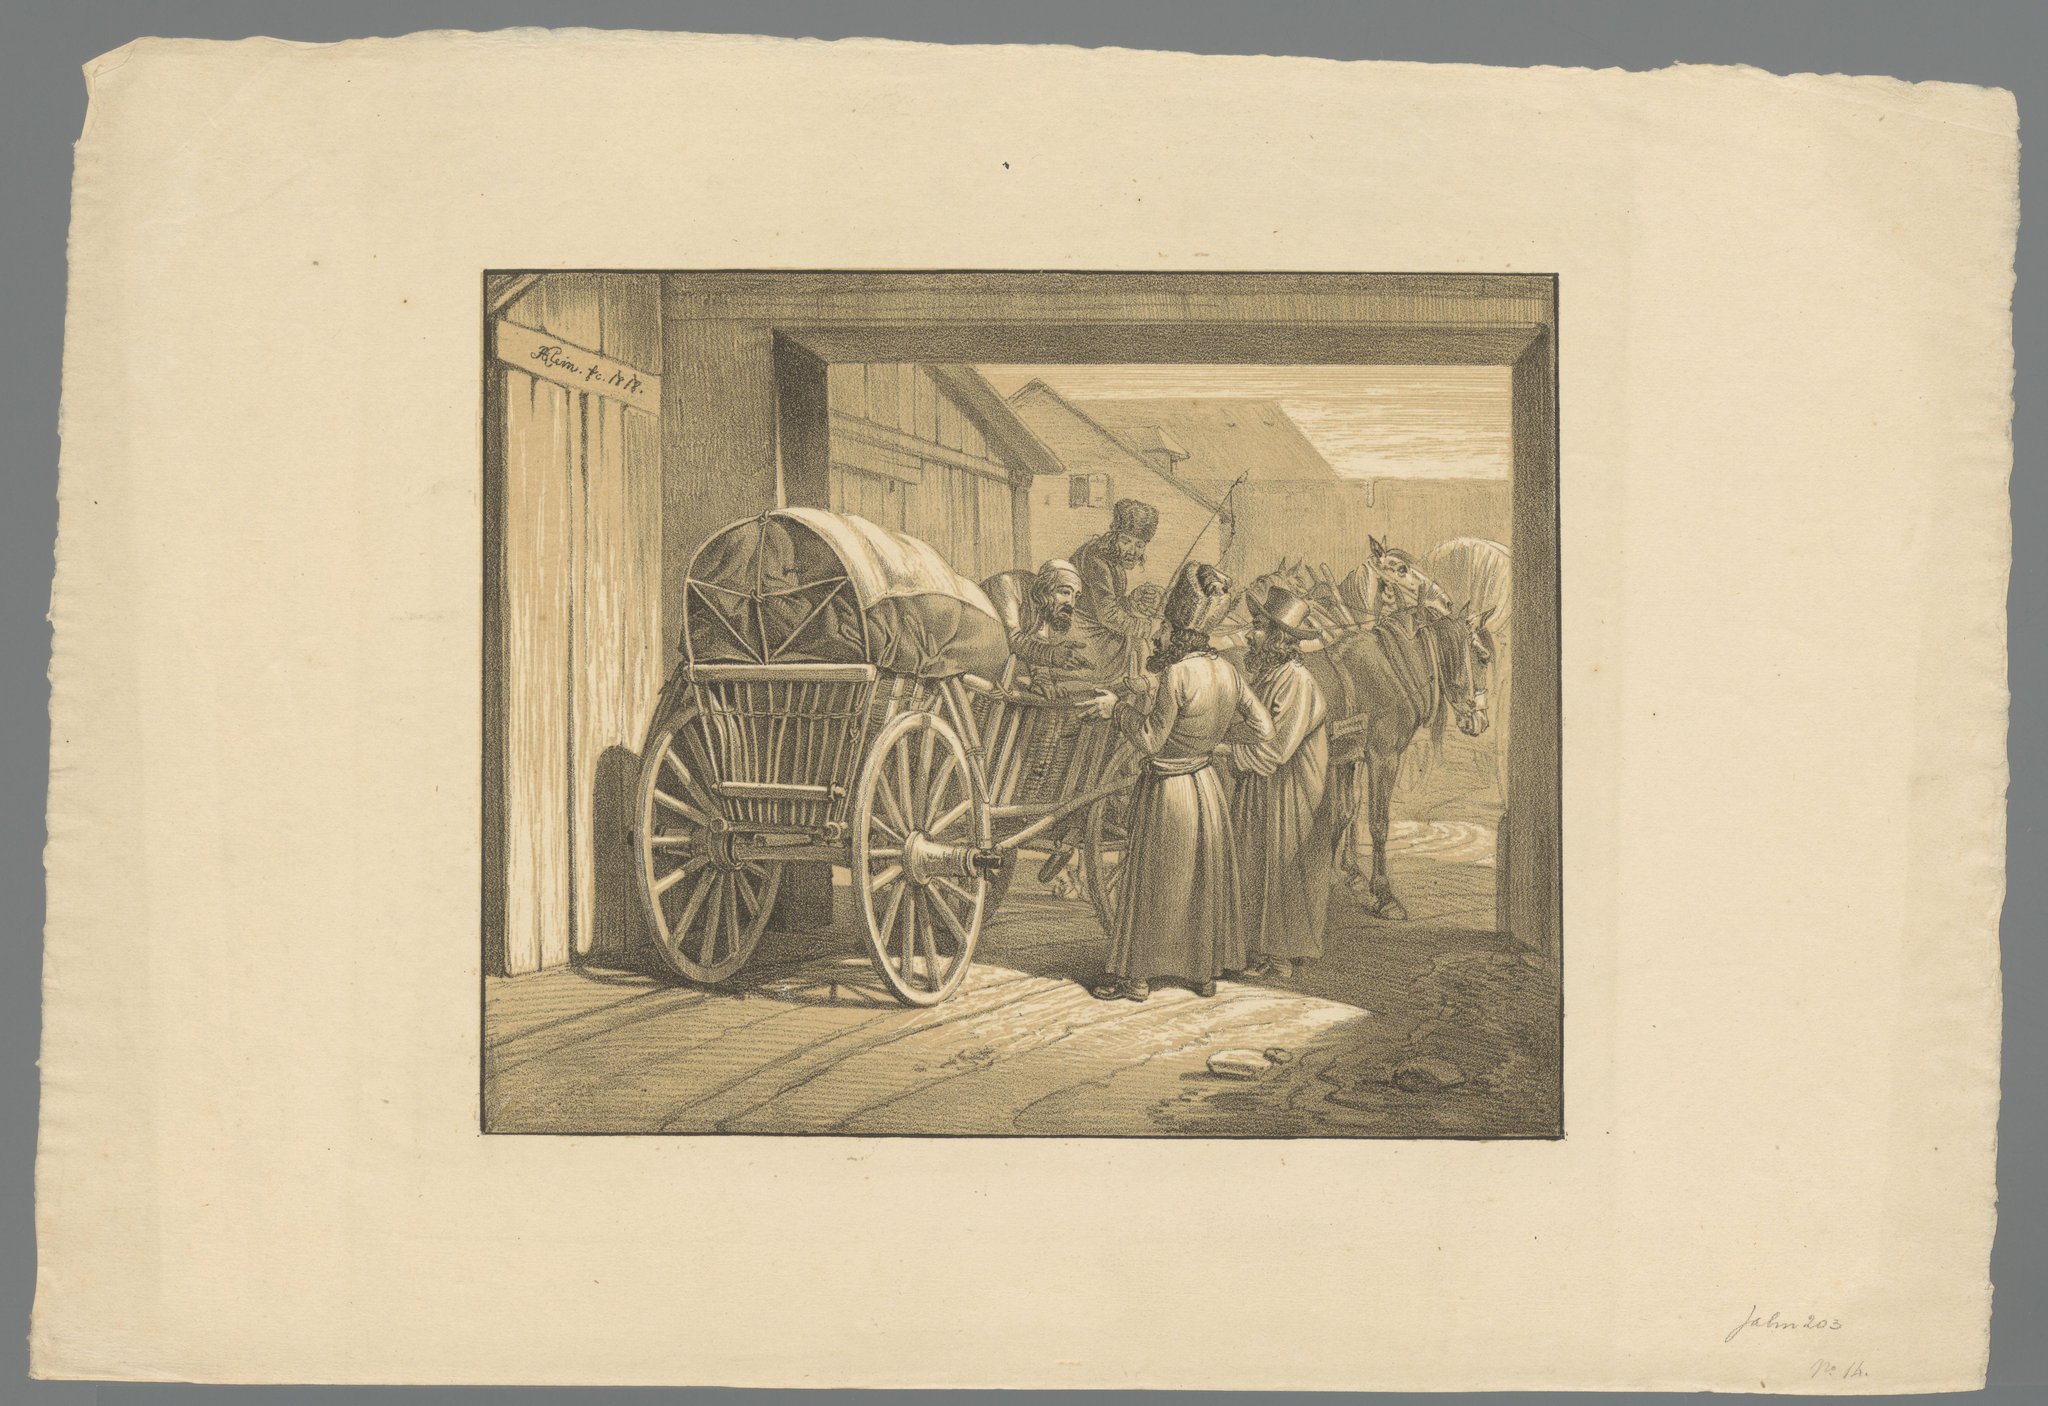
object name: print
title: Vier mannen bij een geladen wagen met paarden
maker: johann adam klein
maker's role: draughtsman, print maker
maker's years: 1792-1875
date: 1818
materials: paper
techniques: tone lithography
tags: four-wheeled, animal-drawn vehicle, e.g.: cab, carriage, coach, departure ~ travelling, the jews, jewish life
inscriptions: inscription: ‘[John] 203’, collector's mark: Lugt 2228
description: Het gaat om het vertrek van Poolse joden bij een poort.